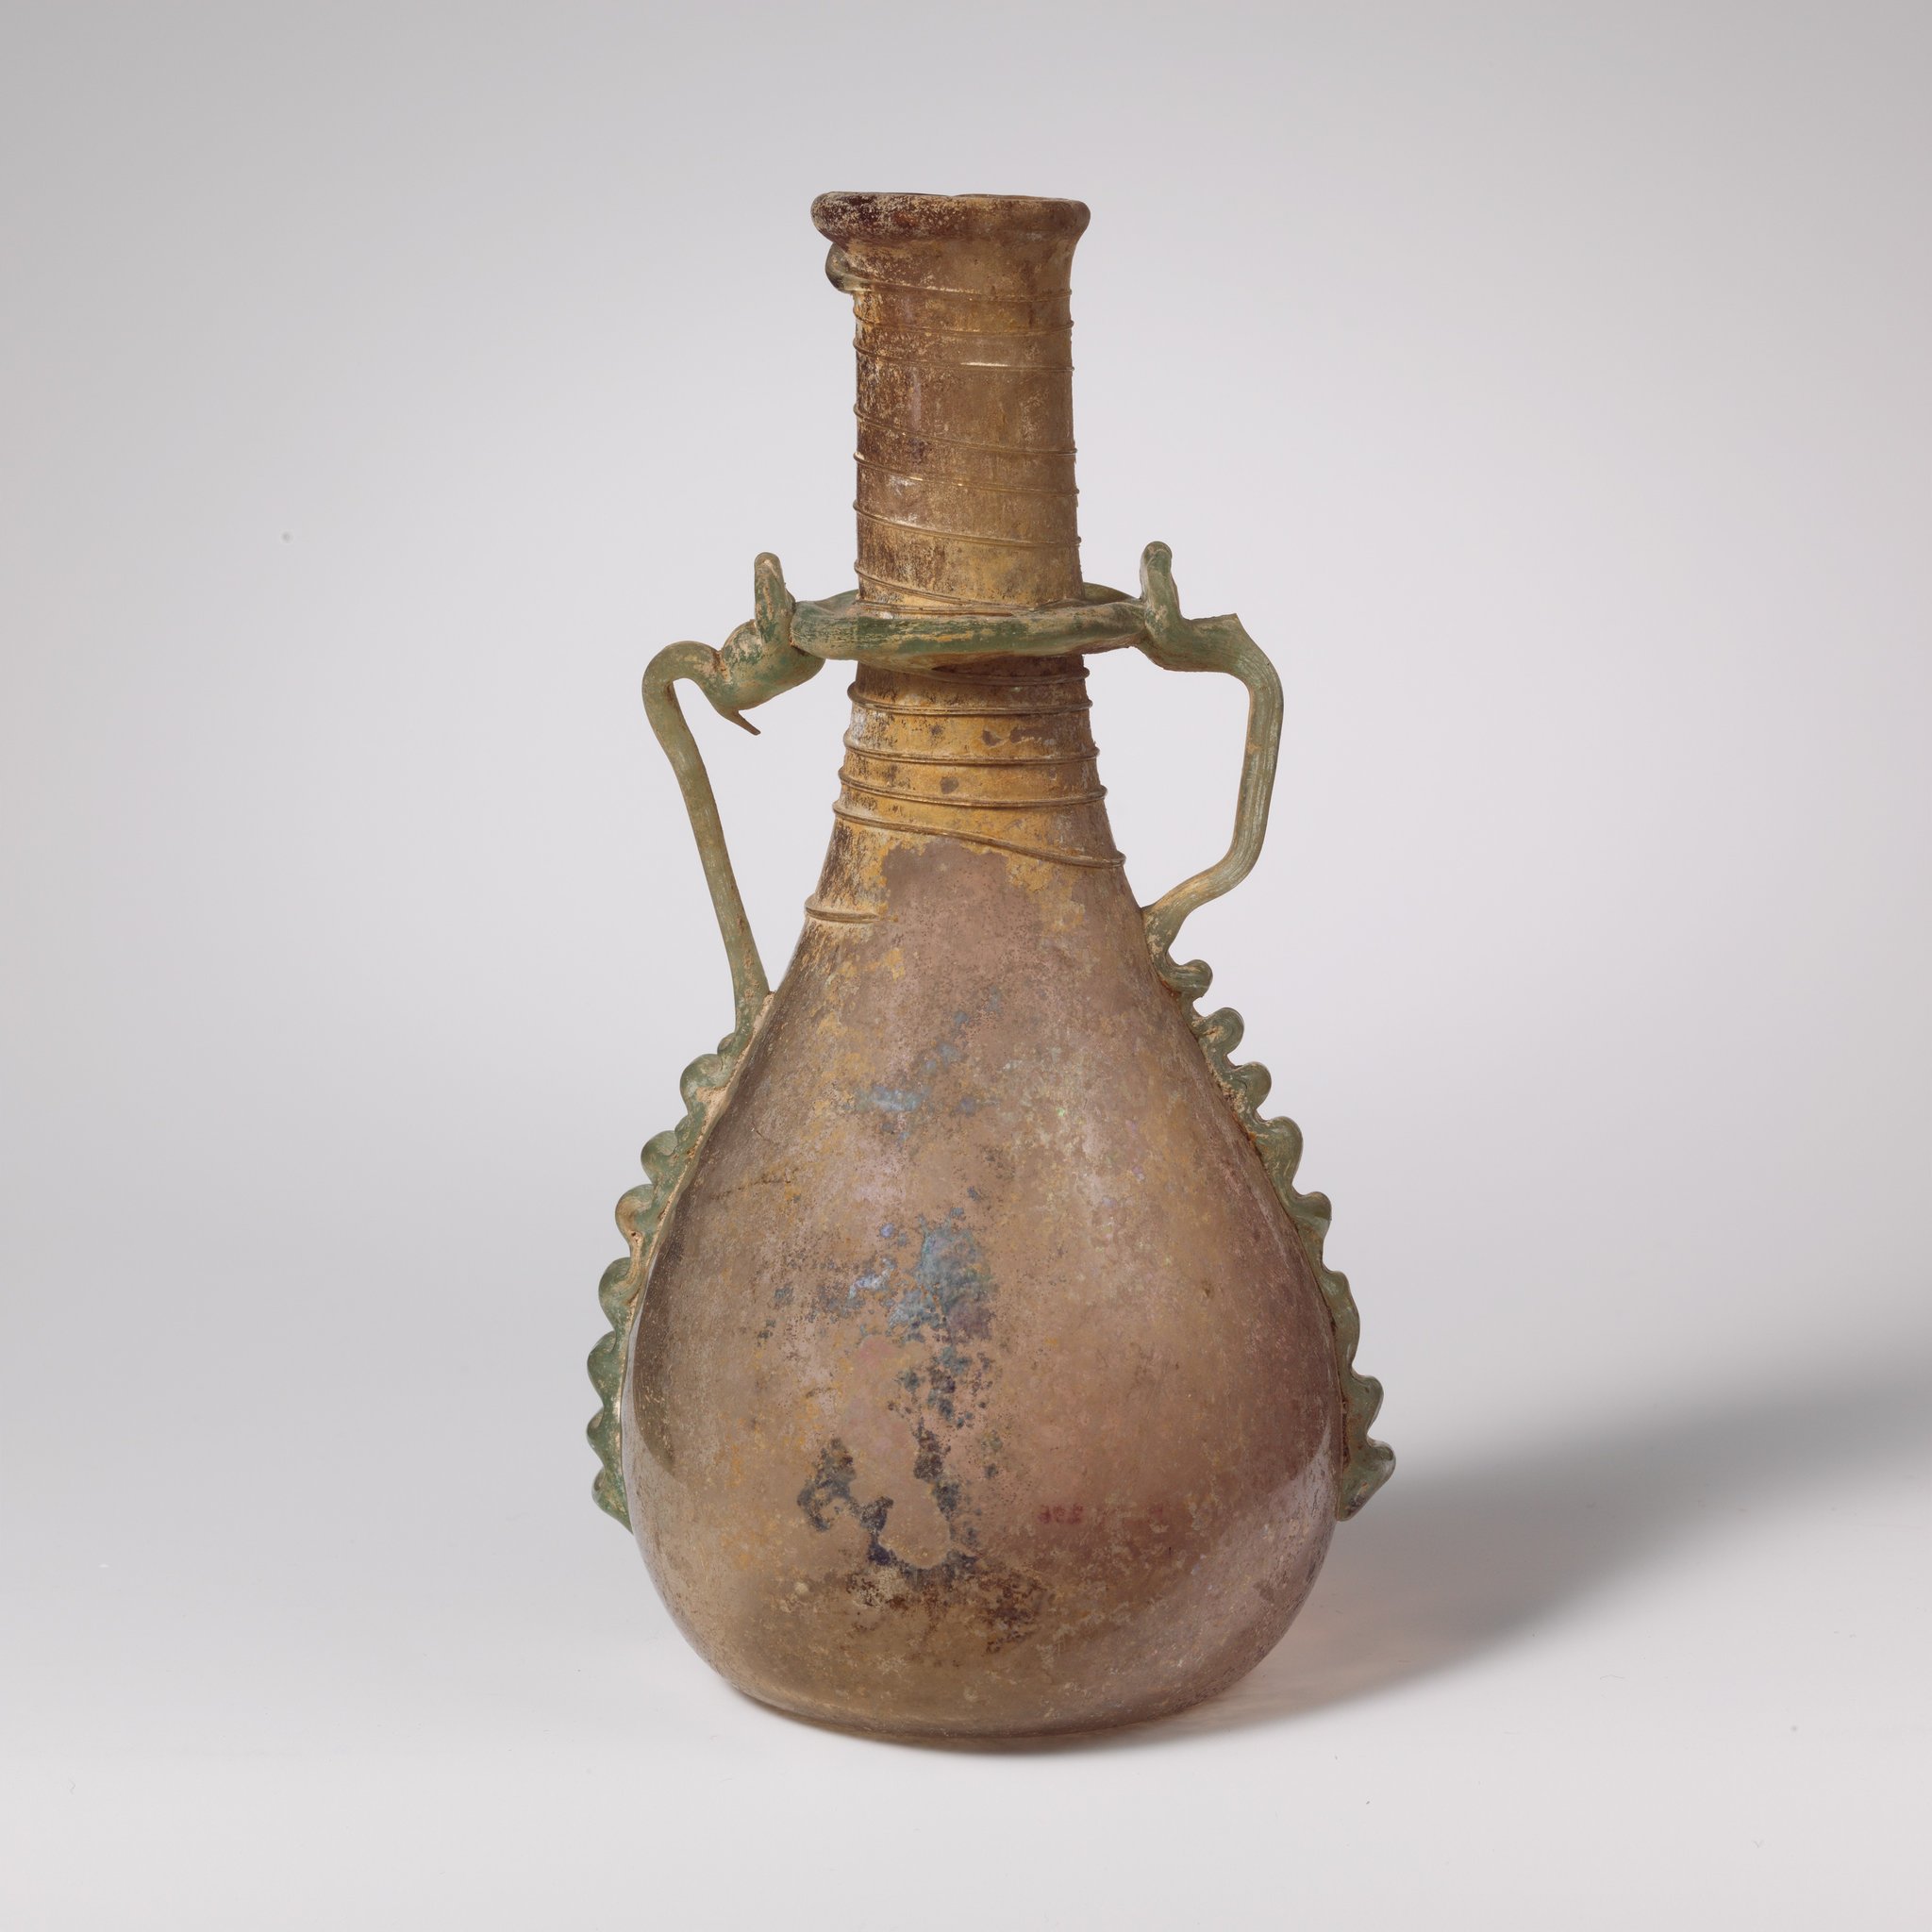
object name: bottle, two handled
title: Glass two-handled bottle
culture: roman, syrian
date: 401-500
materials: glass